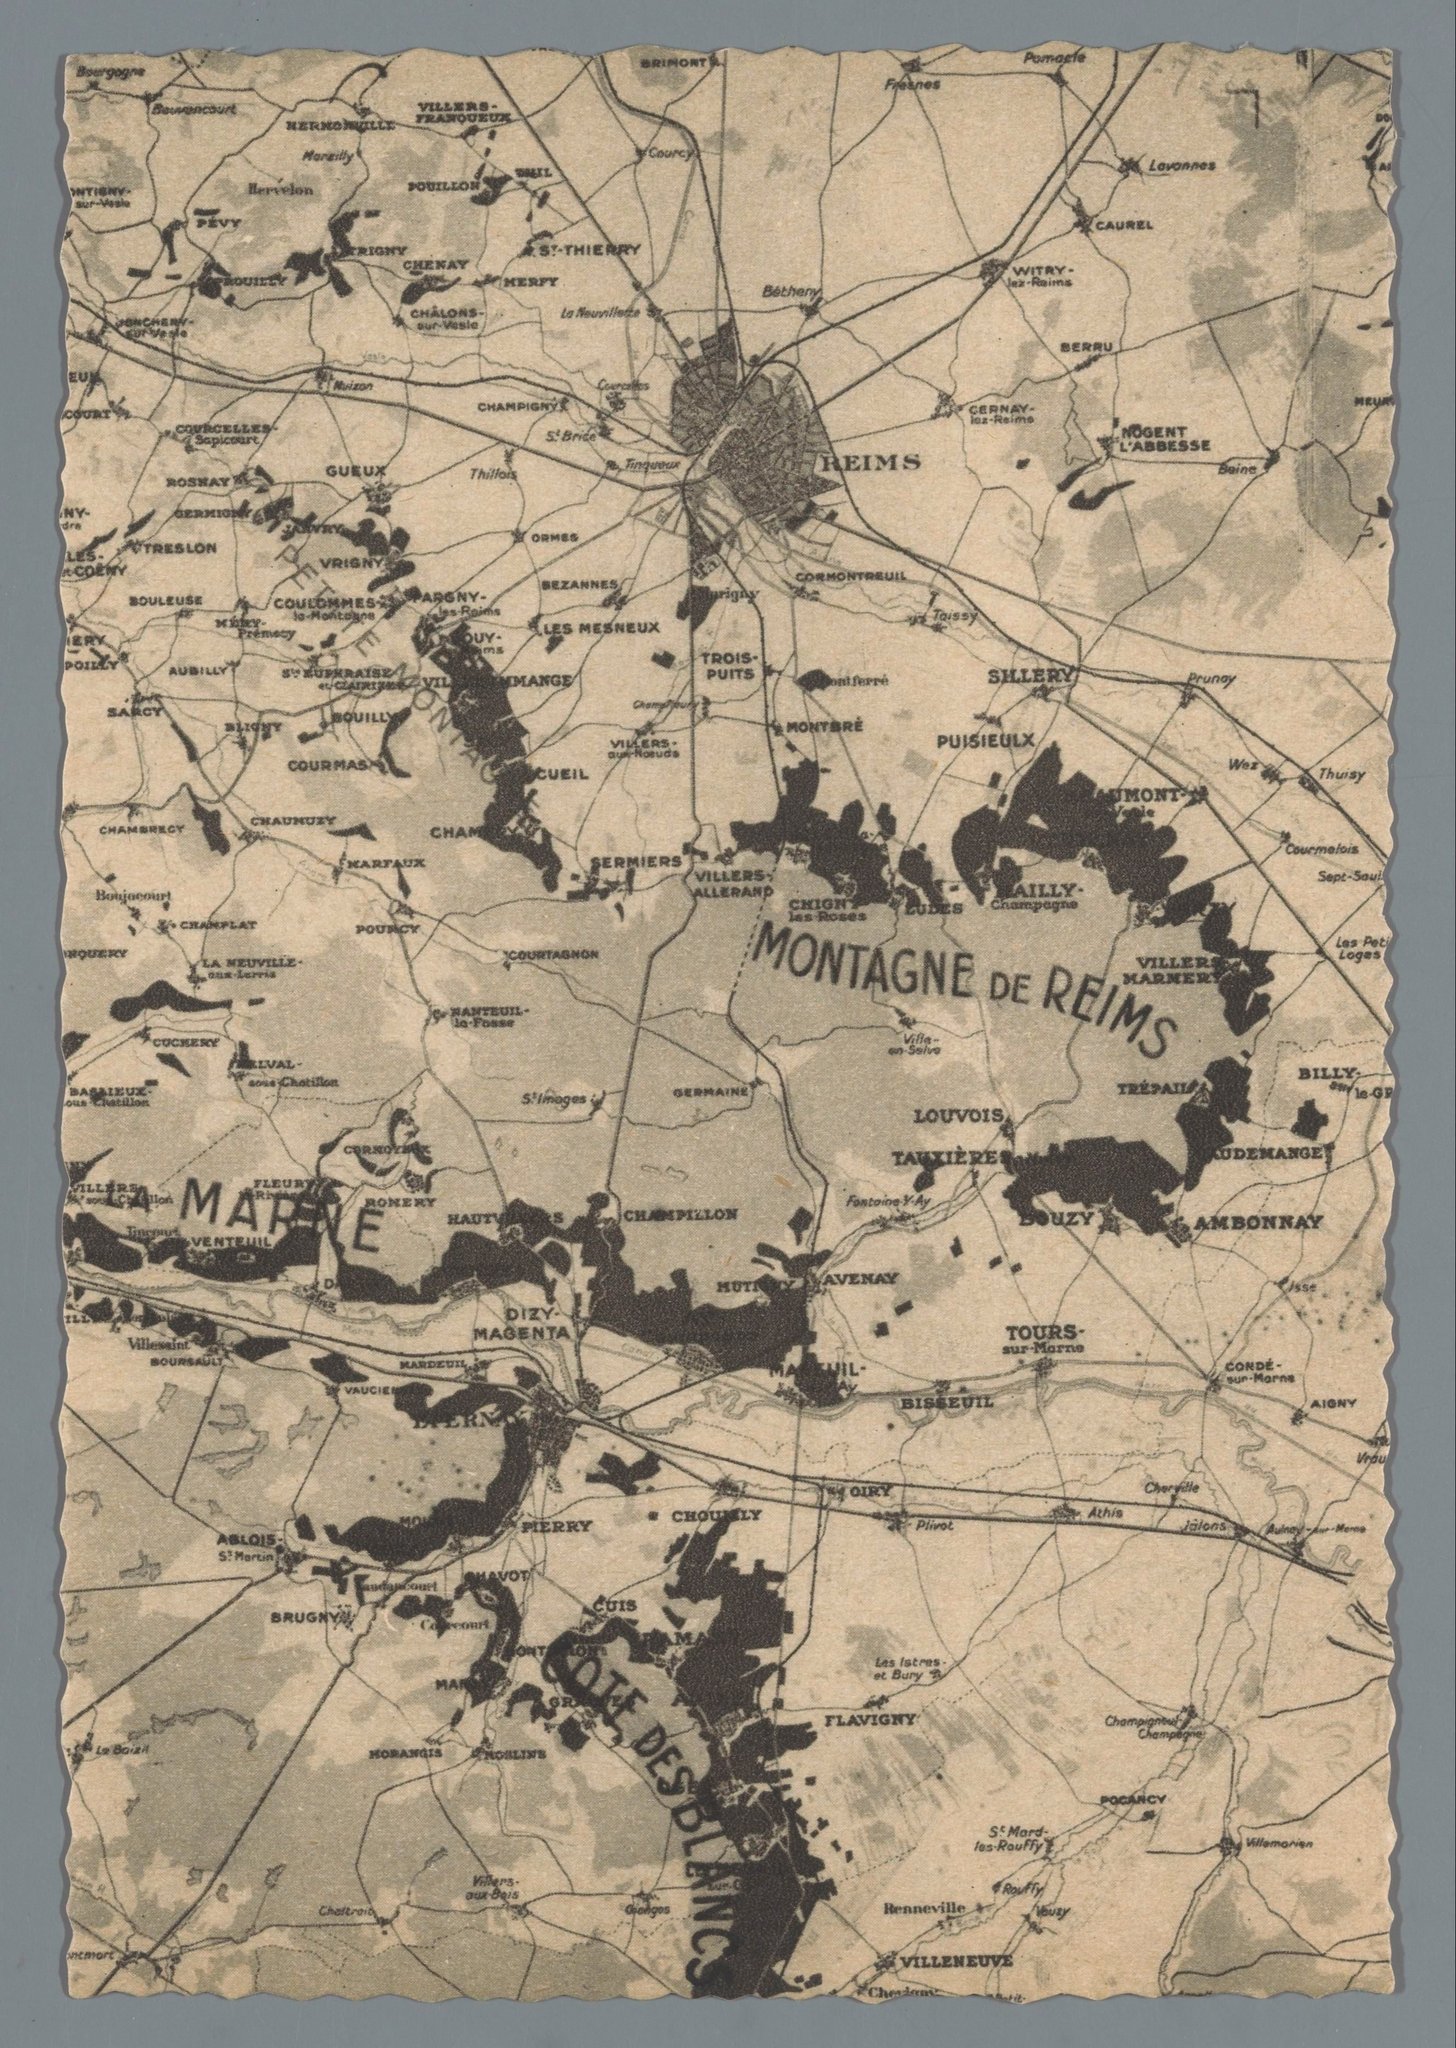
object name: photomechanical print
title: Paris-Reims = 156 kilomètres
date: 1930-1960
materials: paper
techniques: rotogravure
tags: maps, atlases